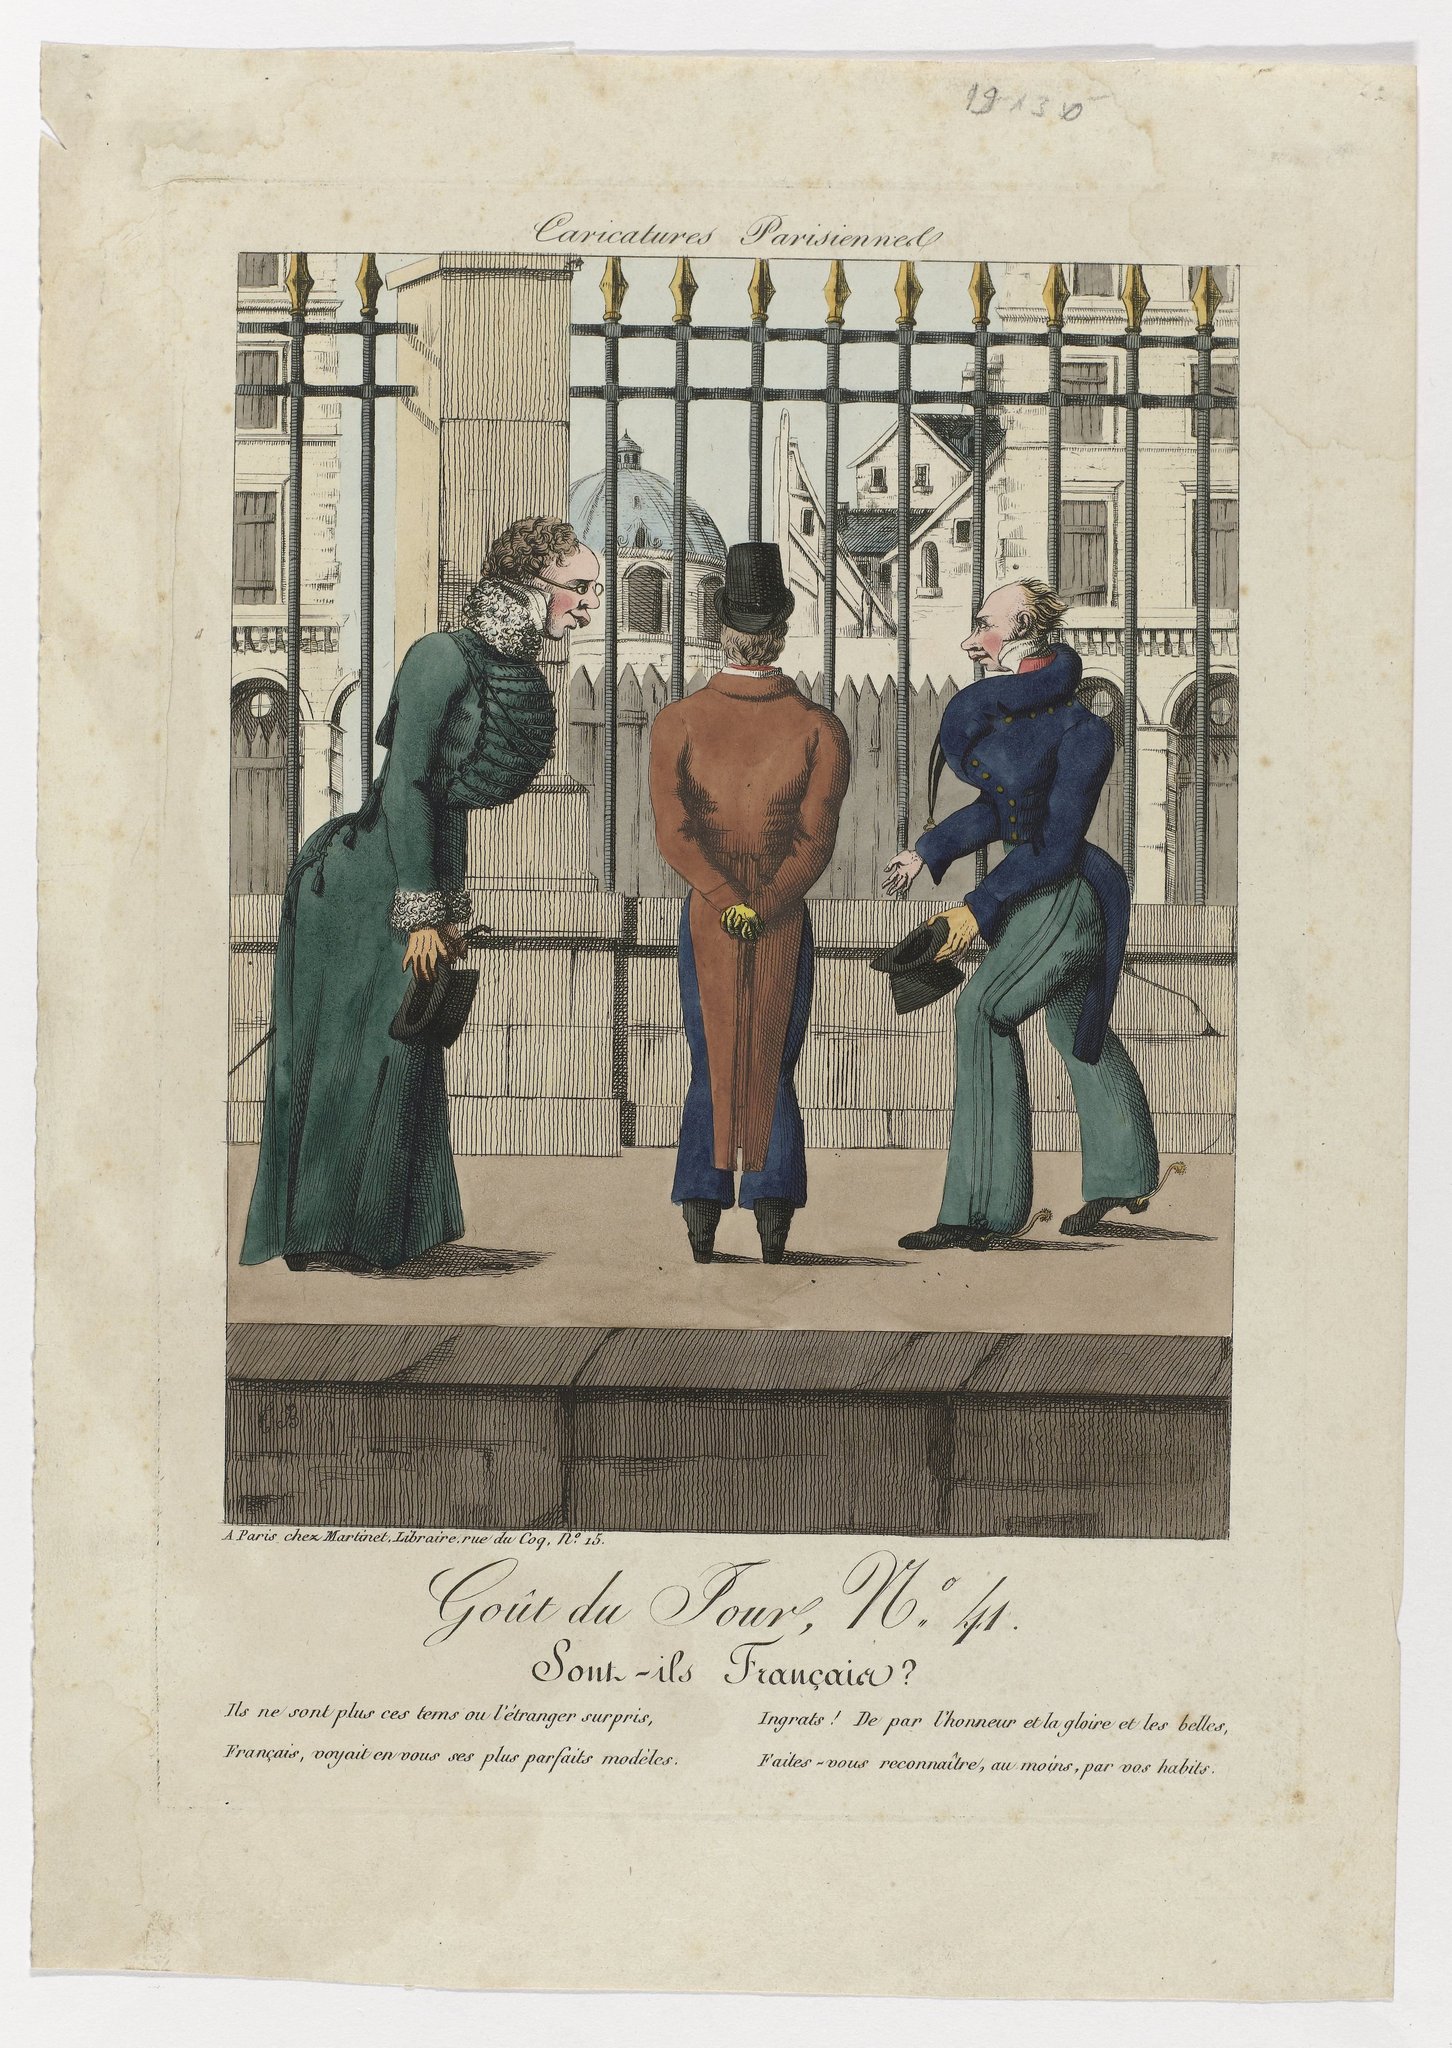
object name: fashion print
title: Goût du Jour, caricatures Parisiennes, 1808, No. 41 : Sont-ils Français? (...)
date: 1808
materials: paper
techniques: engraving, hand coloring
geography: paris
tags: trousers, breeches (+ men's clothes), coat (frac) (+ men's clothes), fence, wall, paling, fashion plates, spur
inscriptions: title: ‘Caricatures Parisiennes’, caption: ‘Ils ne sont plus ces tems ou l'étranger surpris, / Français, voyait en vous ses plus parfairts modèles. / Ingrats! De par l'honneur et la gloire et les belles, / Faites-vous reconnaître, au moins, par vos habits.’, title: ‘Goût du Jour, No 41. / Sont -ils Français?’